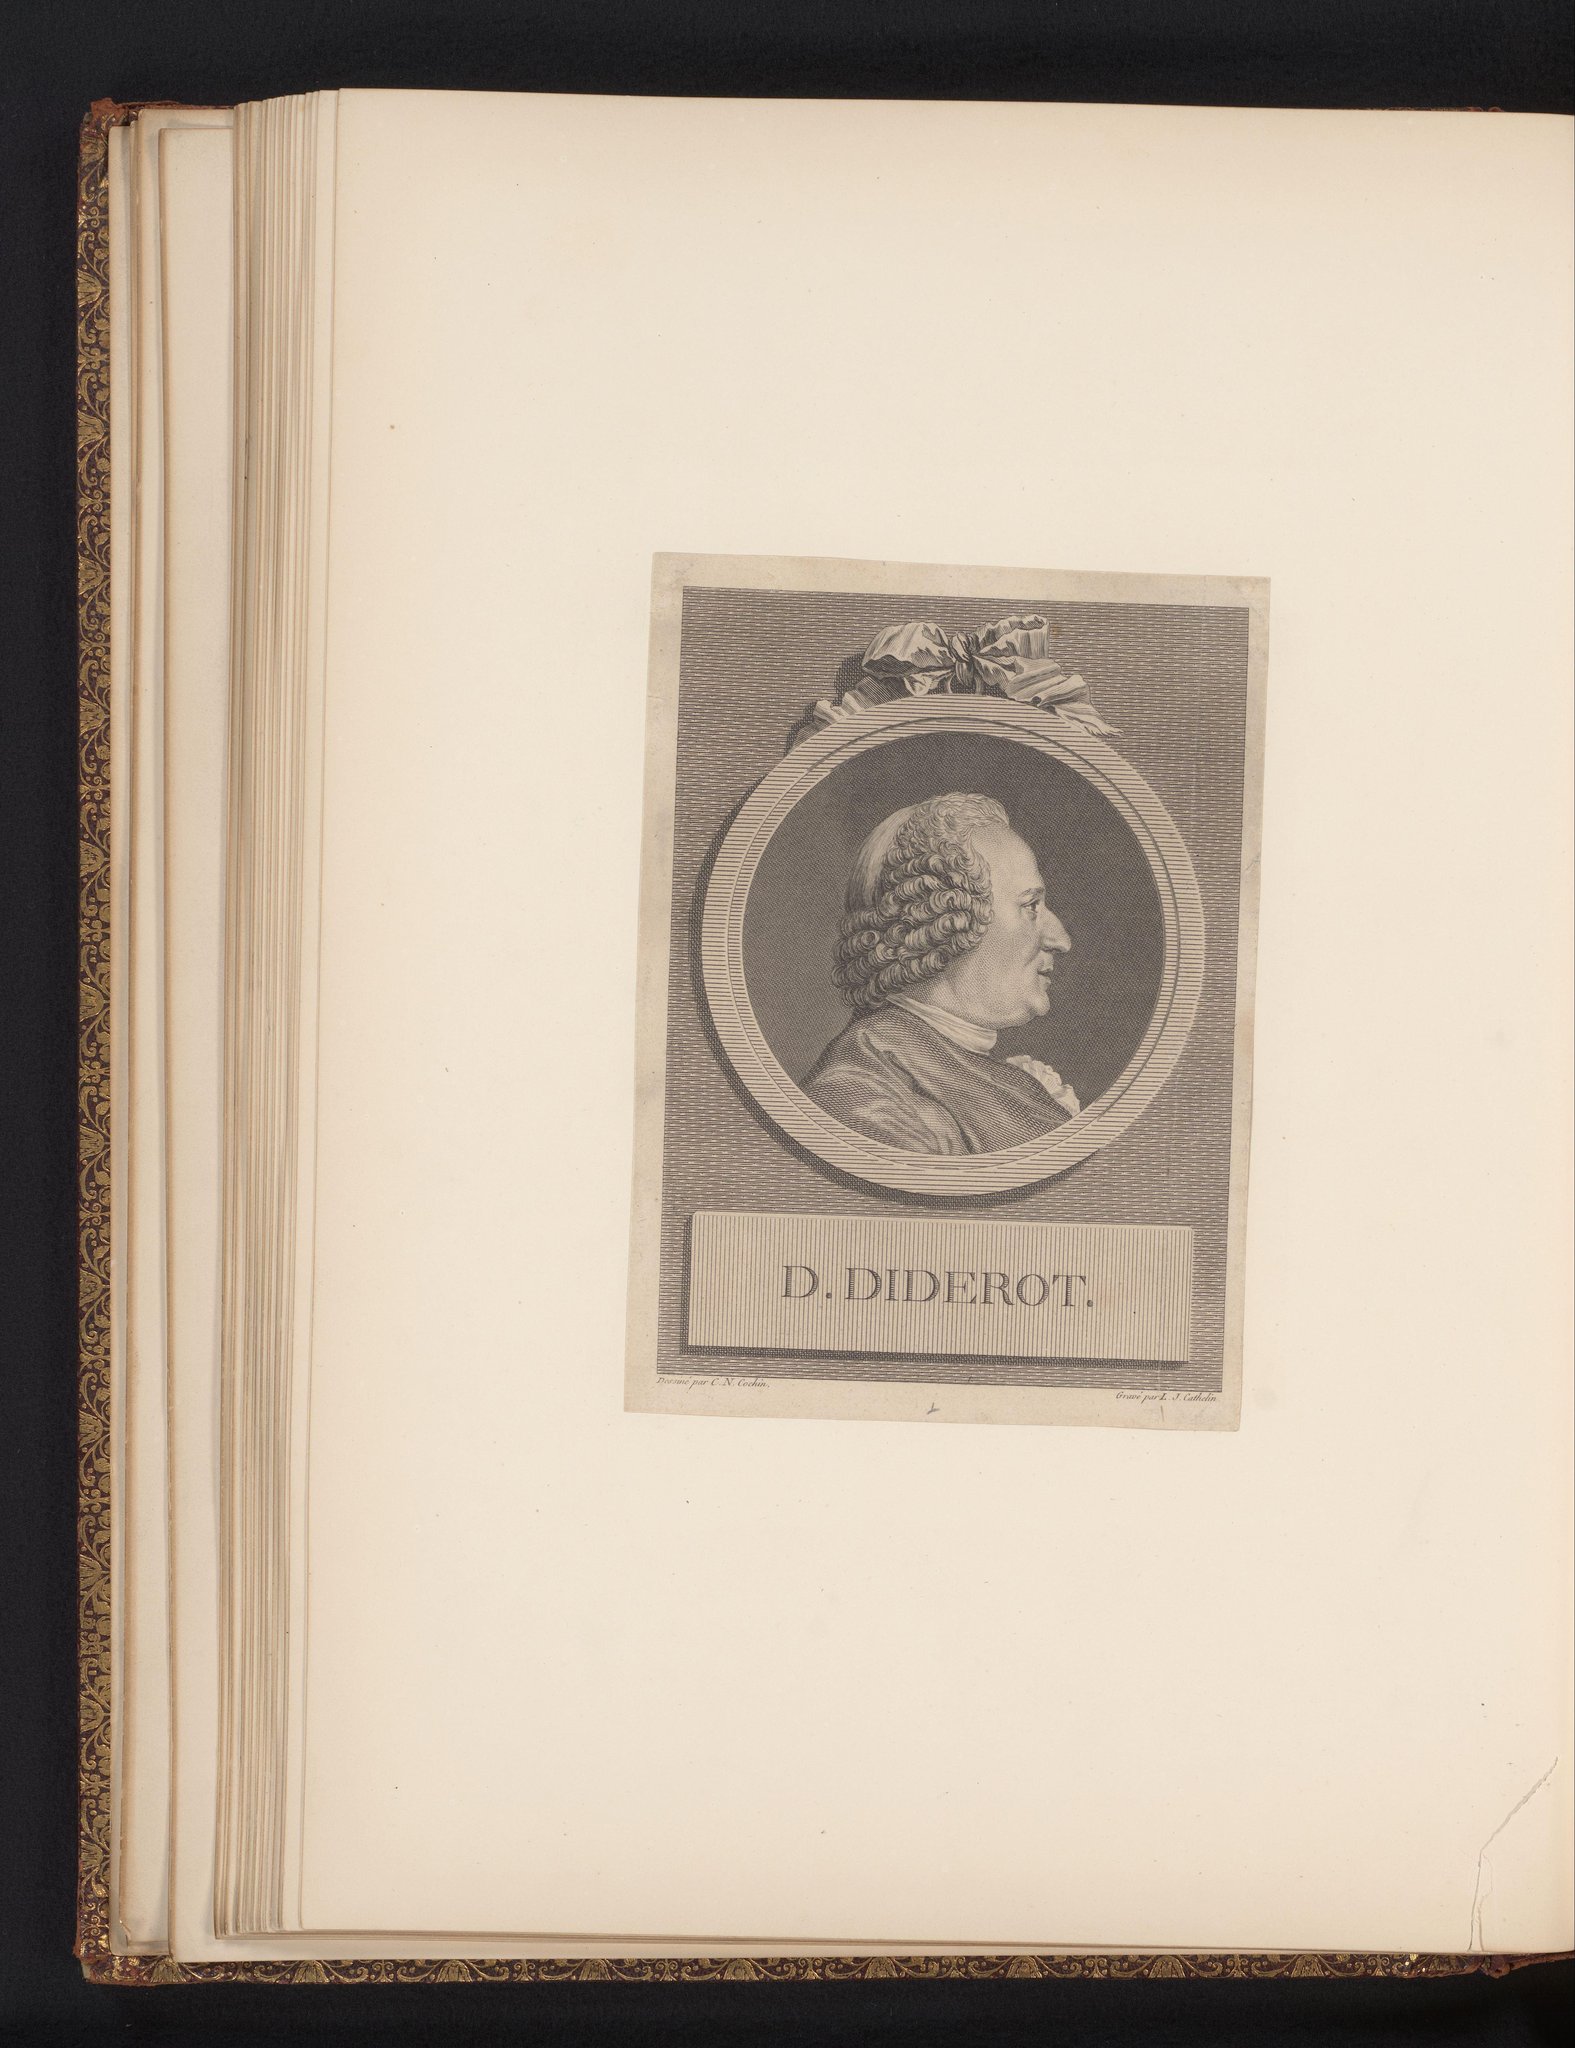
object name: print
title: Portret van Denis Diderot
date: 1748-1804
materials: paper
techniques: engraving, etching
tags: denis diderot, scholar, philosopher, historical persons